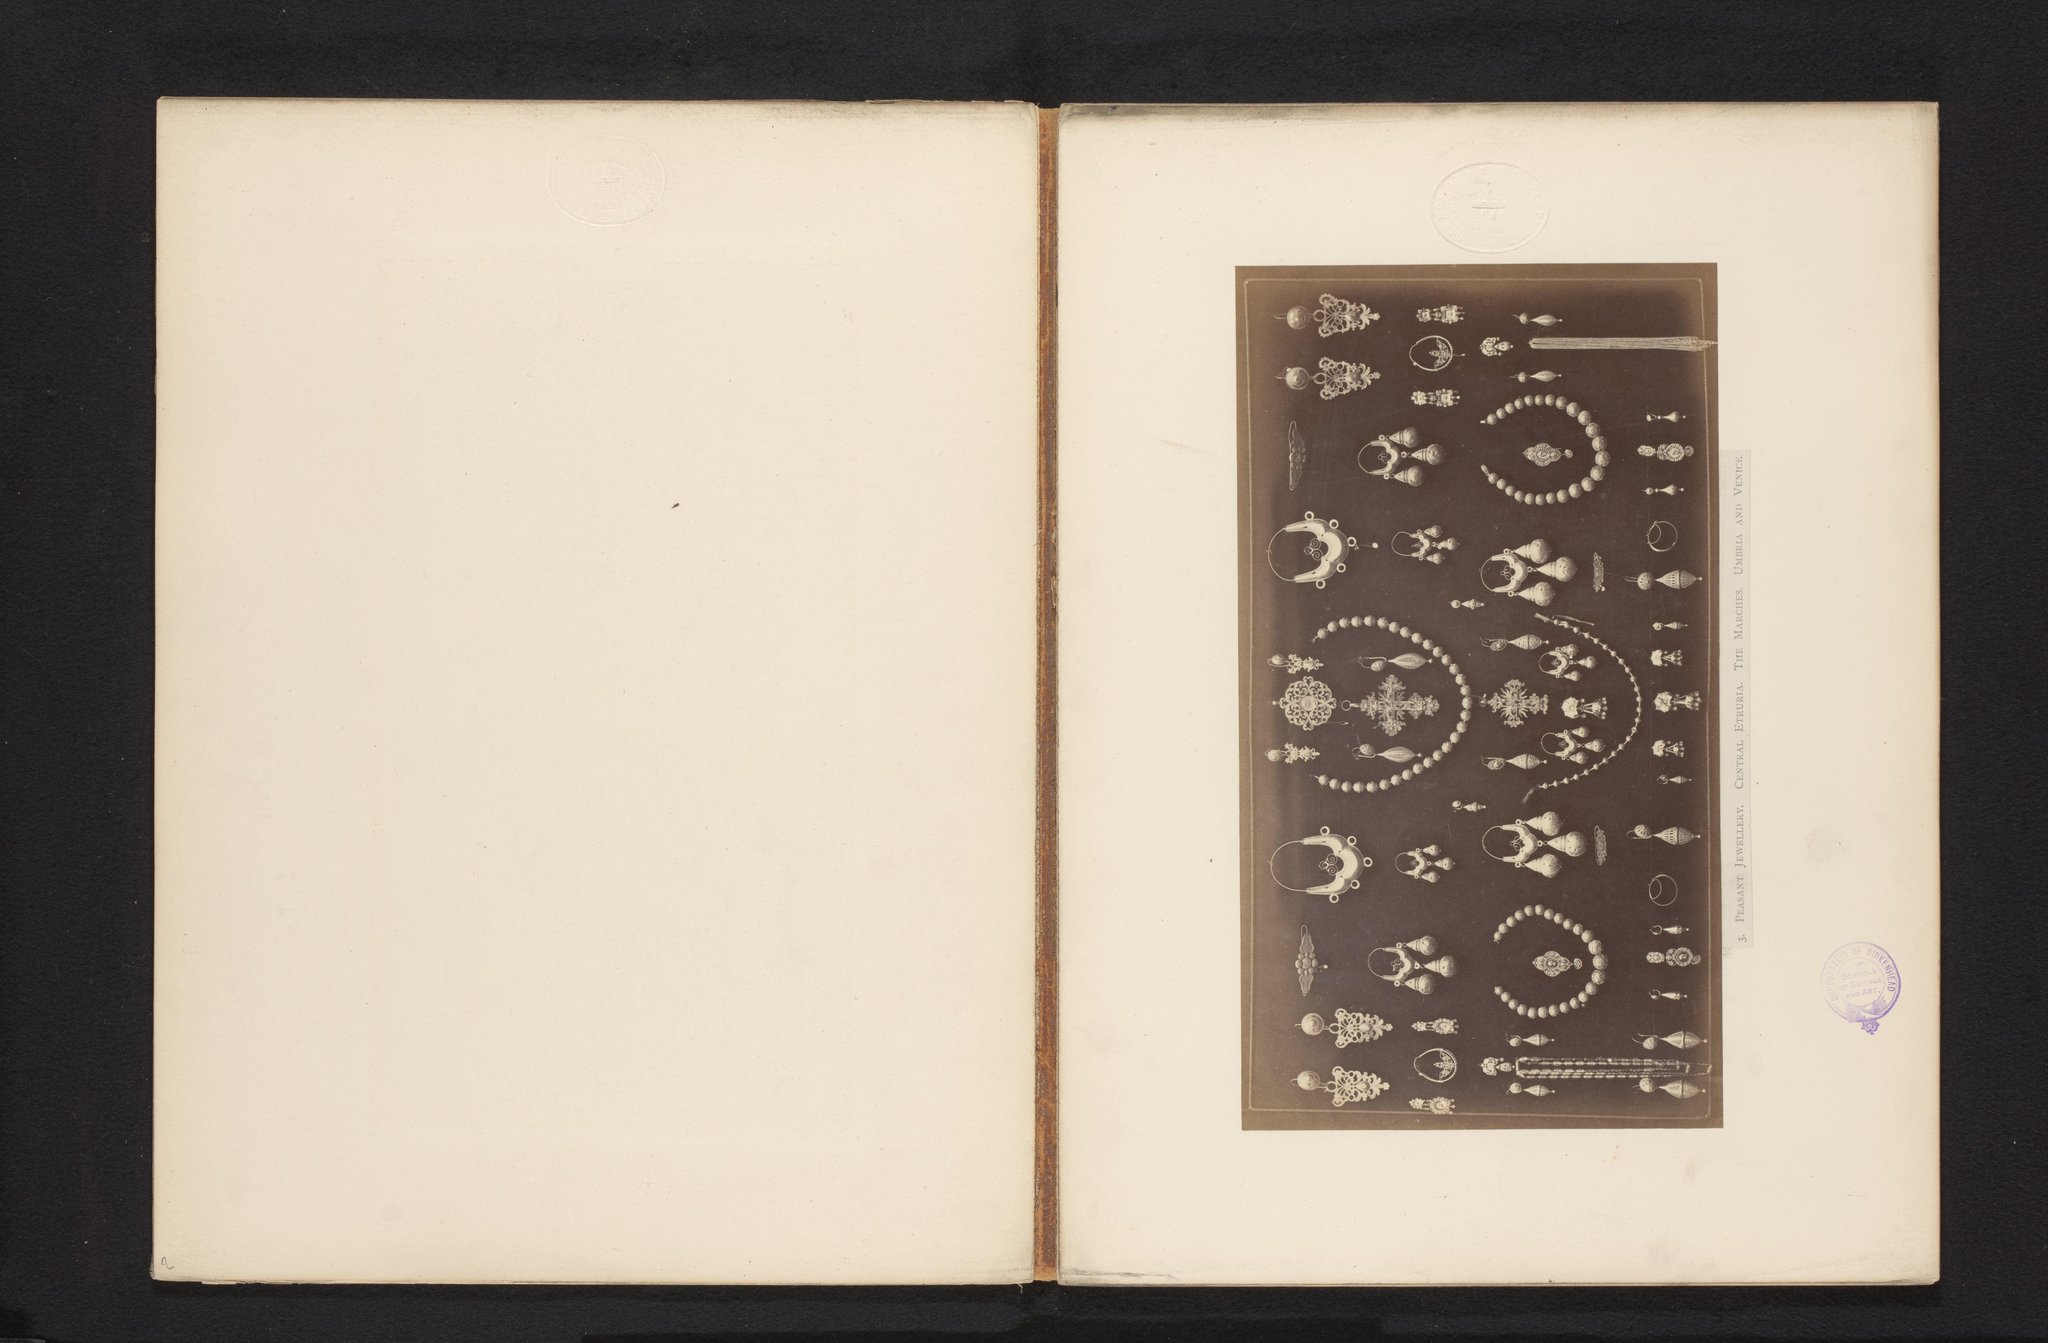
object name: page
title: Sieraden uit de regio van Etruria, Marche, Umbrië en Venetië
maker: Anonymous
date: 1863-1868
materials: photographic support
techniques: albumen print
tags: ornaments, jewels, necklace, ear-rings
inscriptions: collector's mark: ‘South Kensington/ Science and art department’, collector's mark: ‘Corporation of Birkenhead/ schools of science and art’